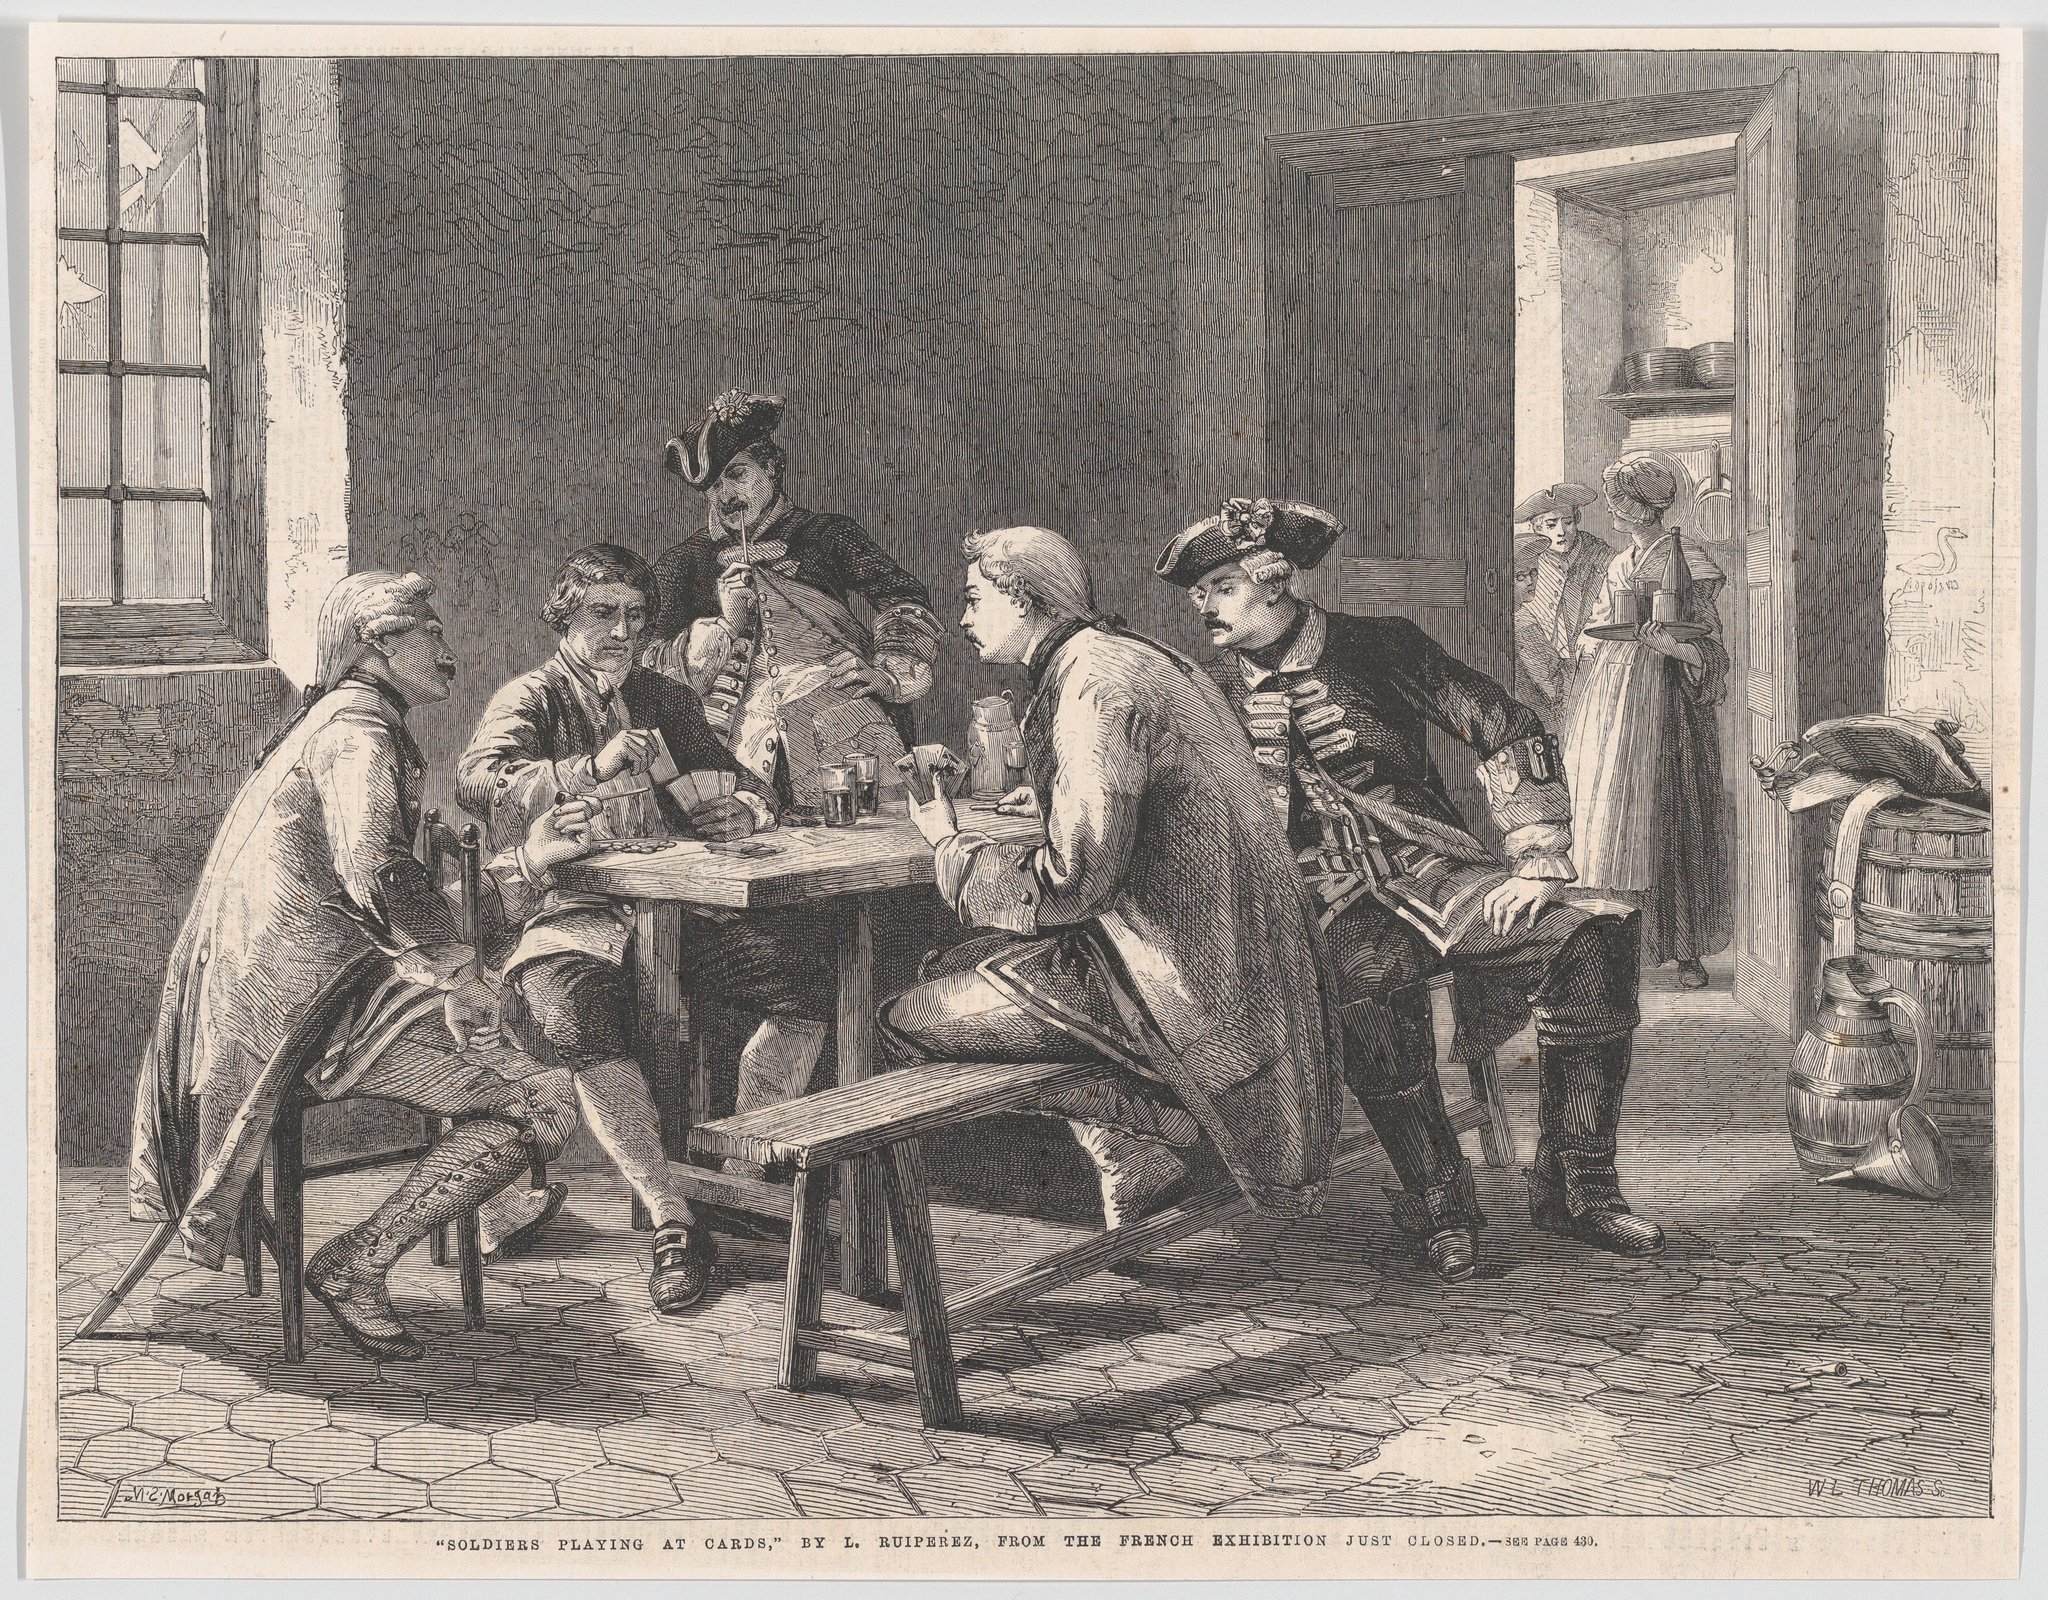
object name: print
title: Soldiers Playing at Cards, from "Illustrated London News"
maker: william luson thomas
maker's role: engraver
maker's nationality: british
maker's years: 1830-1900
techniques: engraving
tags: interiors,soldiers,men,playing cards